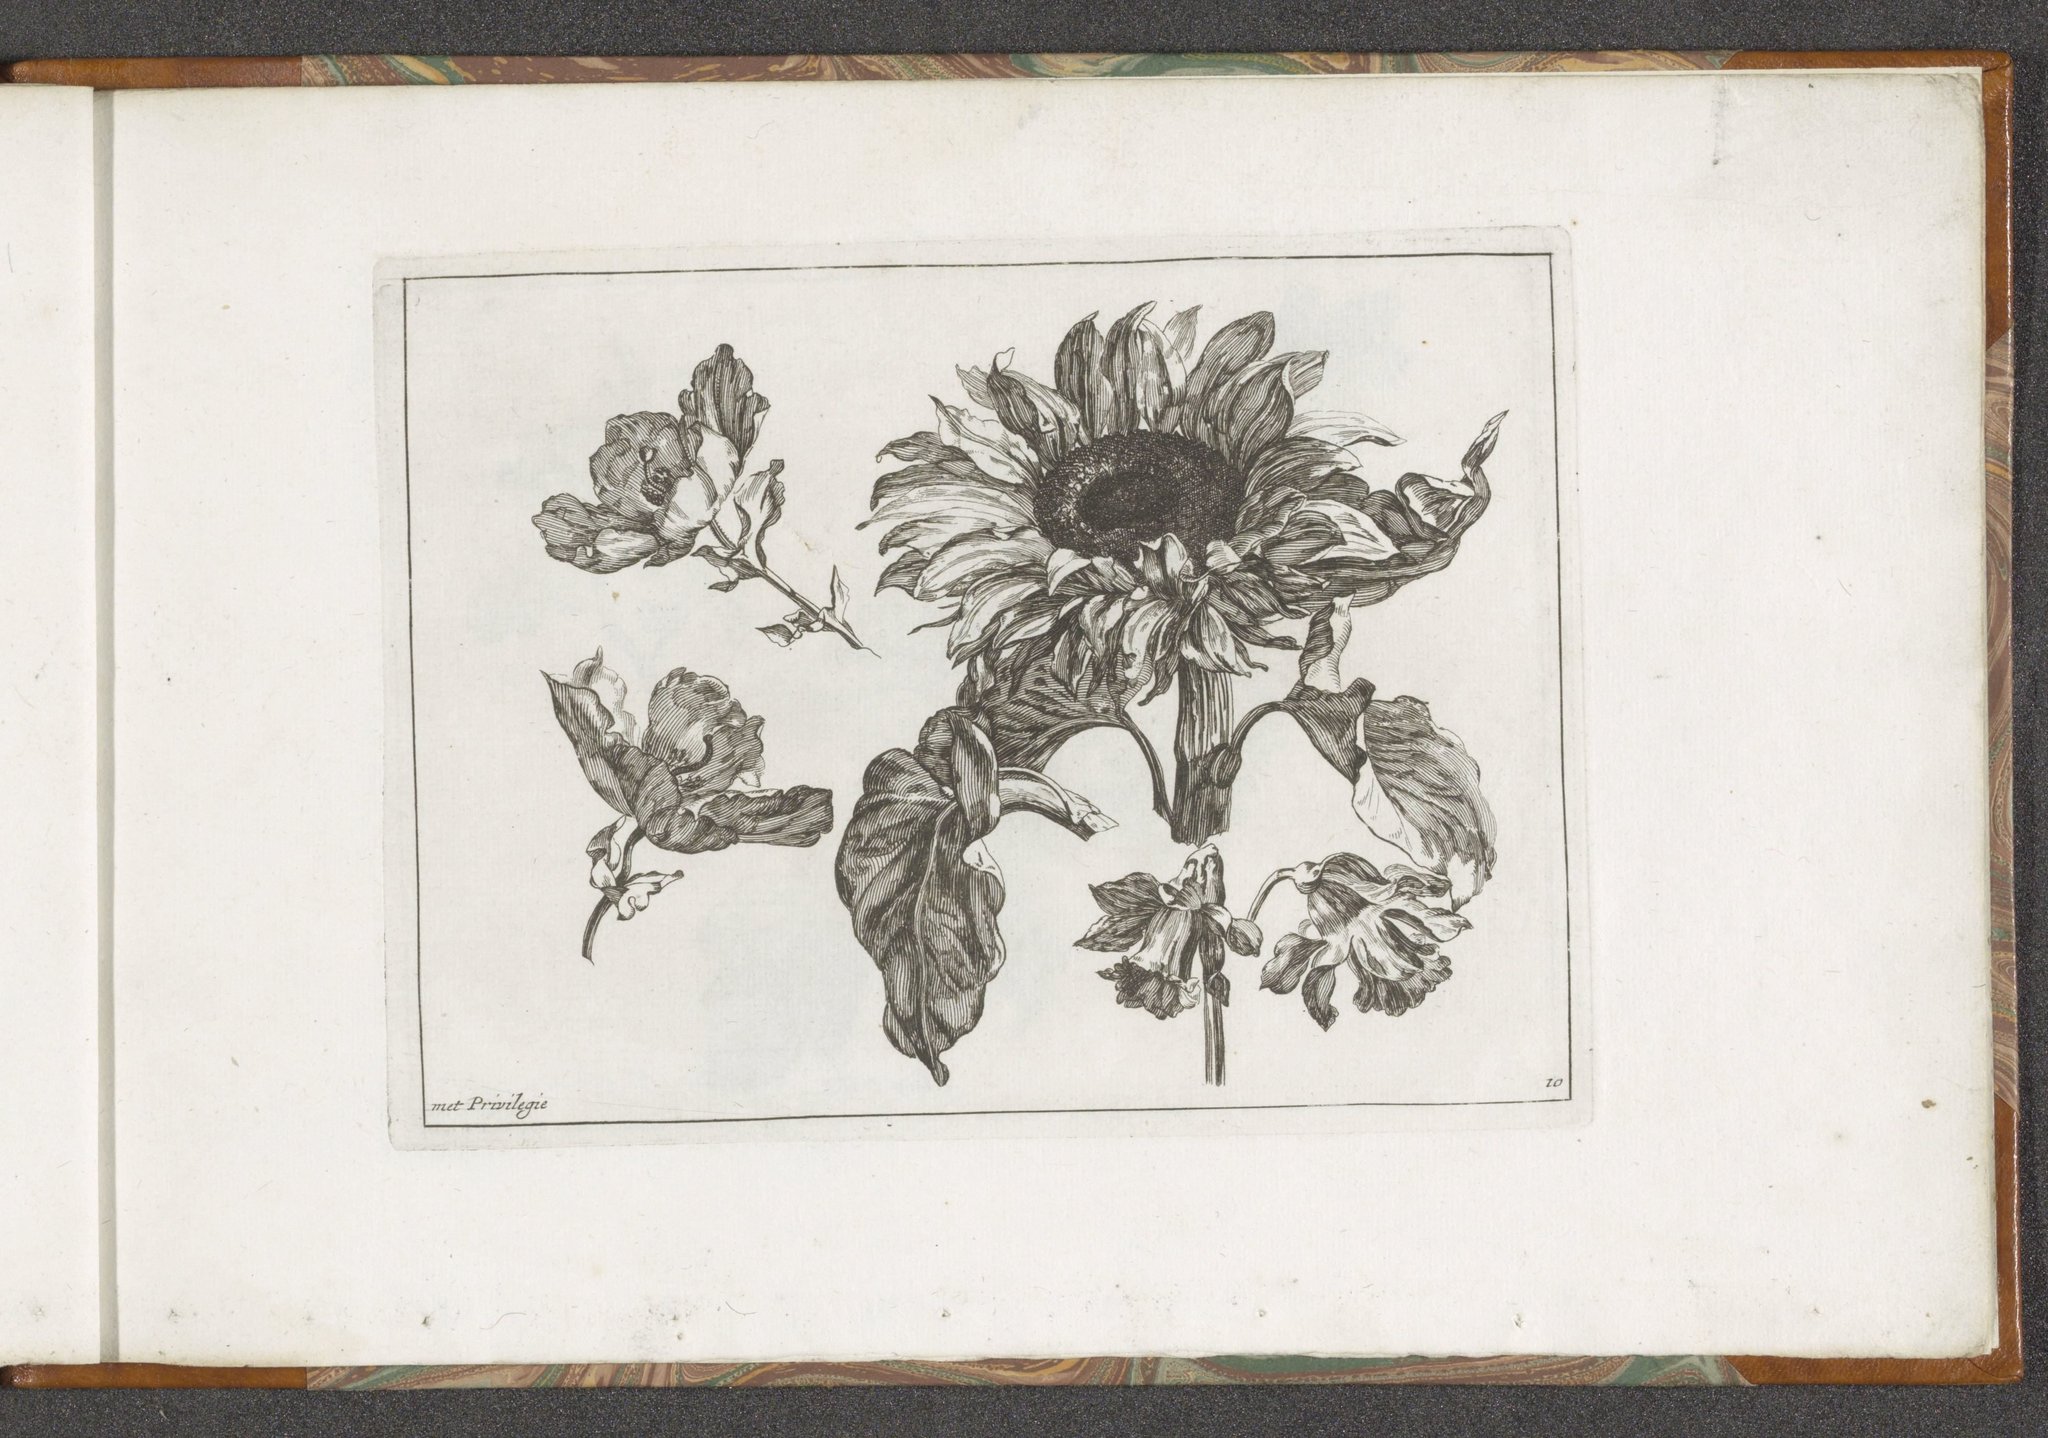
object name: album leaf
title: Zonnebloem en narcis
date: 1630-1718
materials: paper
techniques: etching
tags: flowers: sunflower, flowers: narcissus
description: Deze prent maakt deel uit van een album.